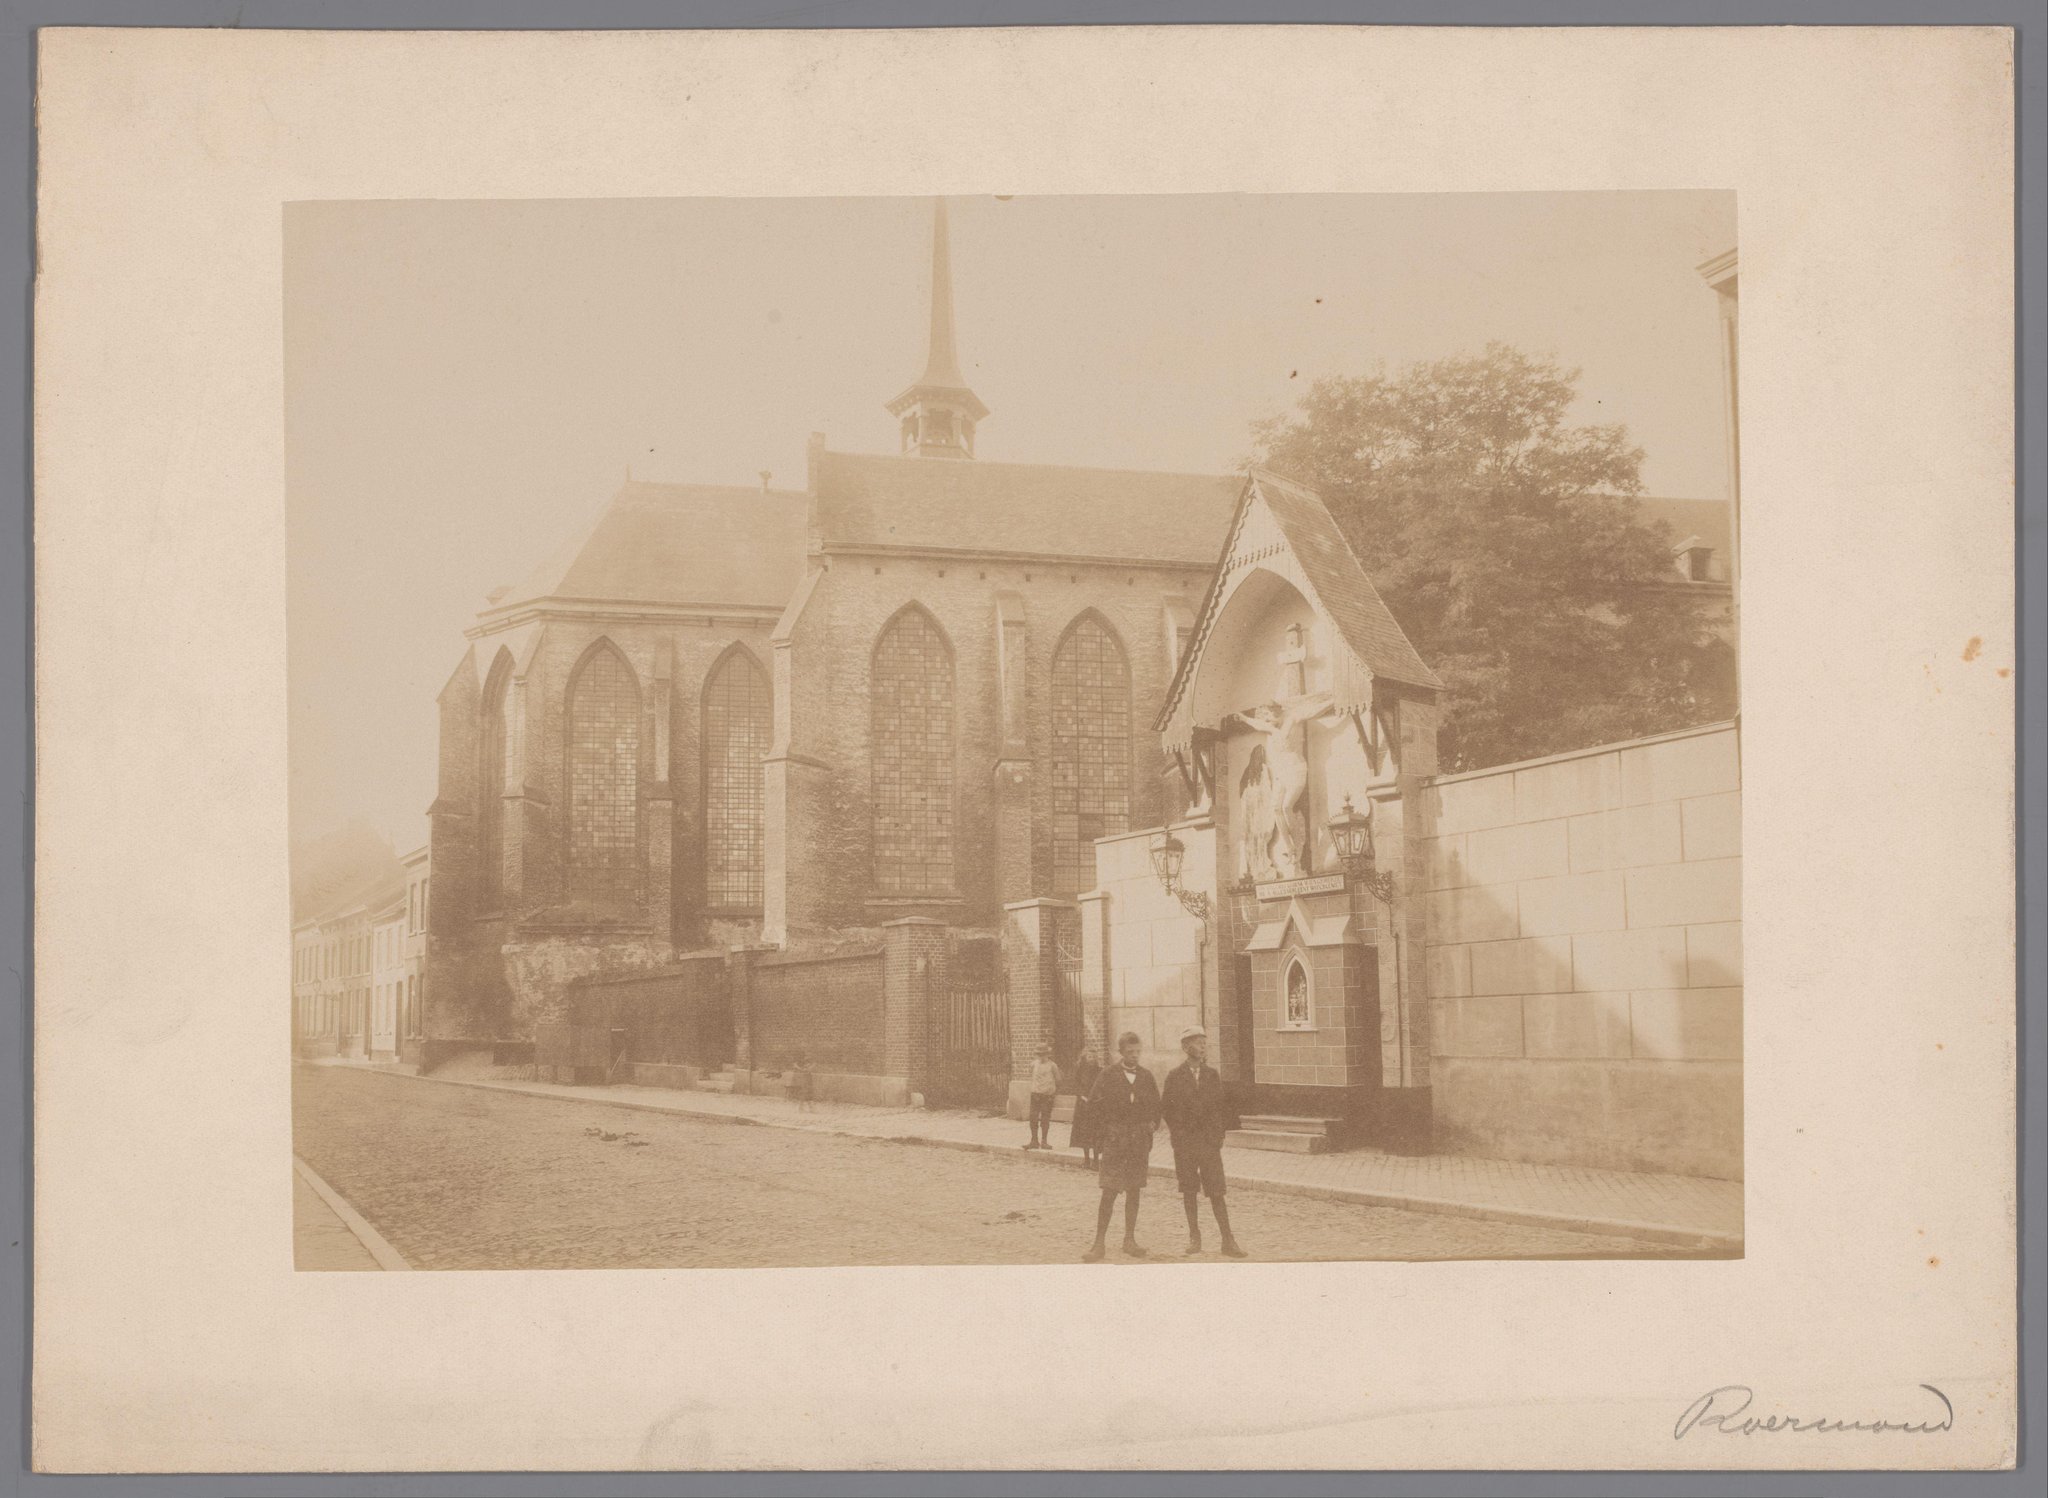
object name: photograph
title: Gezicht op de Minderbroederskerk te Roermond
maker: anoniem (monumentenzorg)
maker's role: fotograaf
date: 1901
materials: cardboard, photographic support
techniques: albumen print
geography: roermond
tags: church (exterior), street (+ city(-scape) with figures, staffage)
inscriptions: annotation: ‘Roermond/ Ned. Herv. kerk/ aug 1901’, annotation: ‘Roermond’